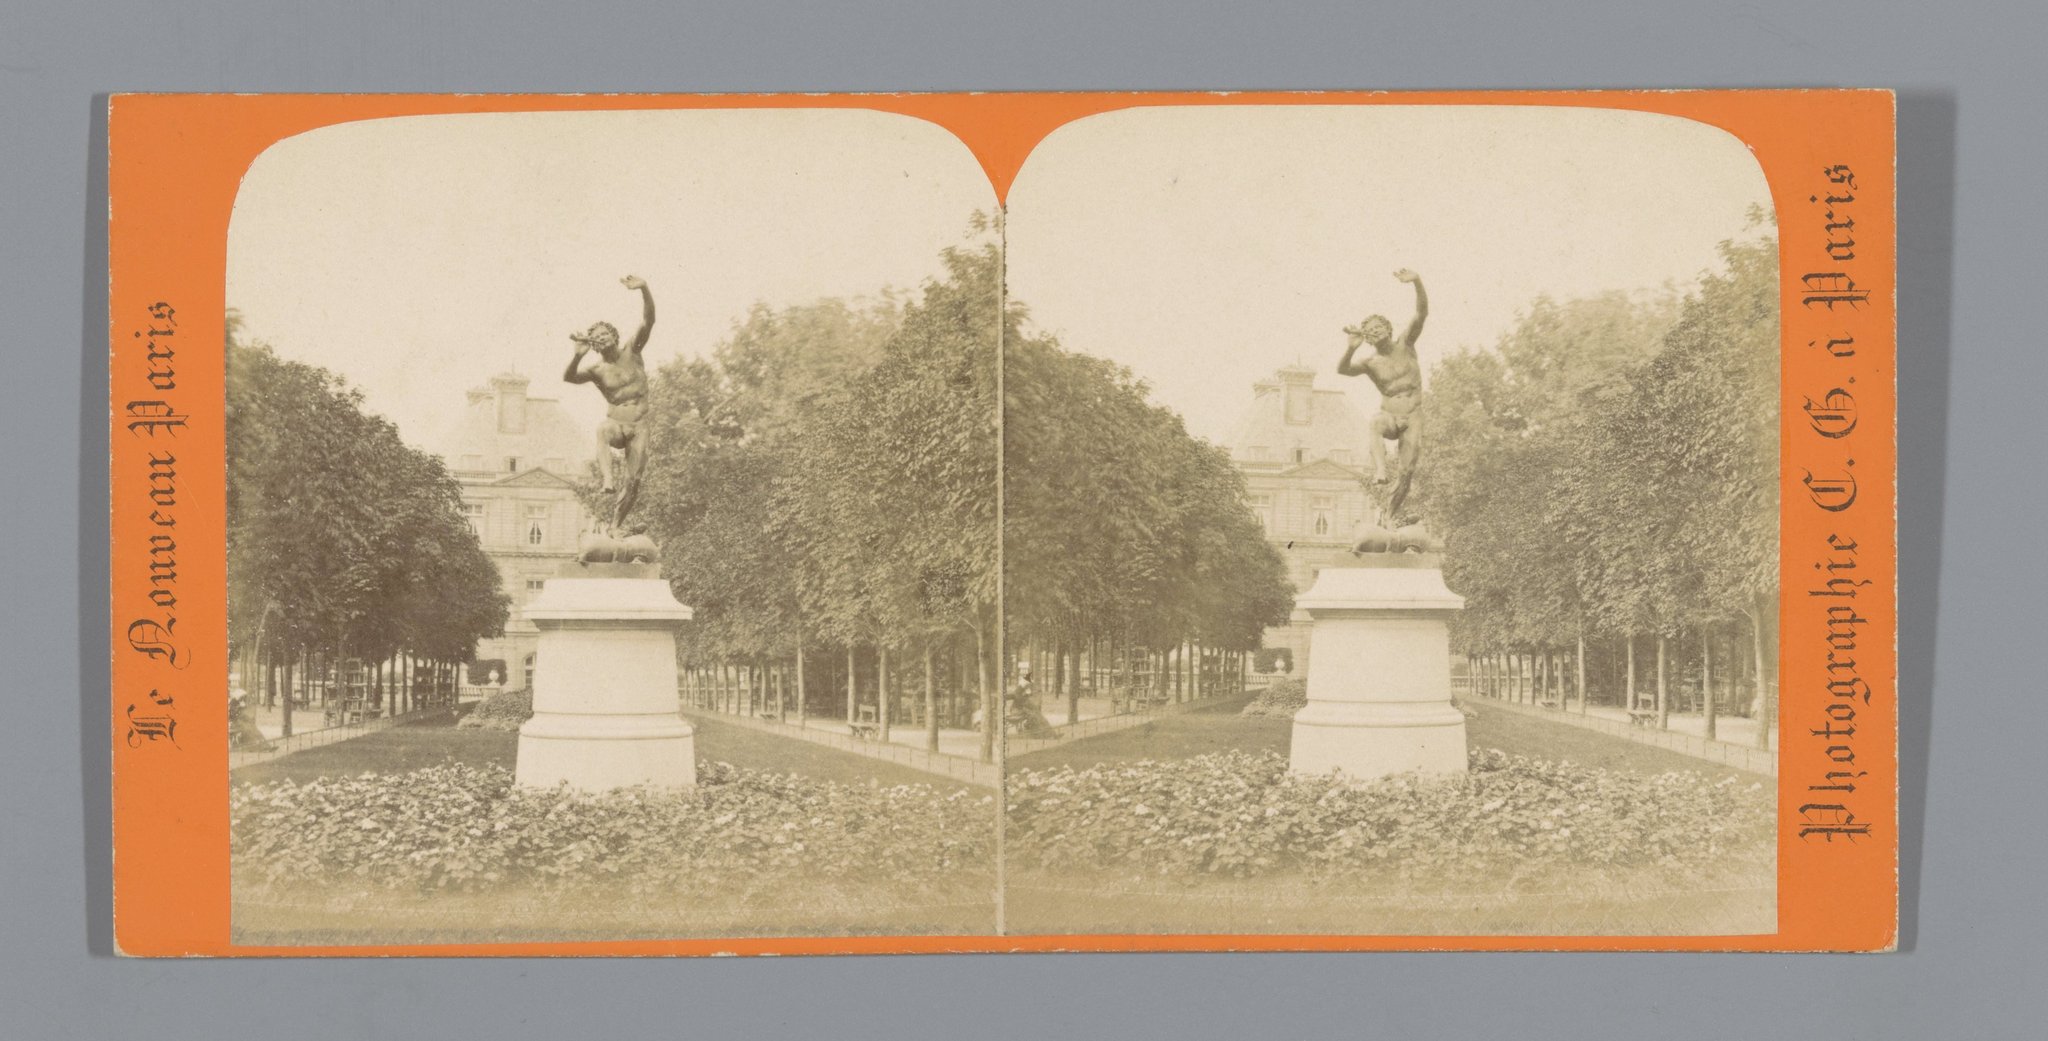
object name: stereograph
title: Le Nouveau Paris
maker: charles gérard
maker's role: fotograaf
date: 1850-1875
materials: cardboard, photographic support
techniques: albumen print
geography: jardin du luxembourg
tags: satyrs, fauns, sileni, sculpture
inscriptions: inscription: ‘Le Luxembourg’